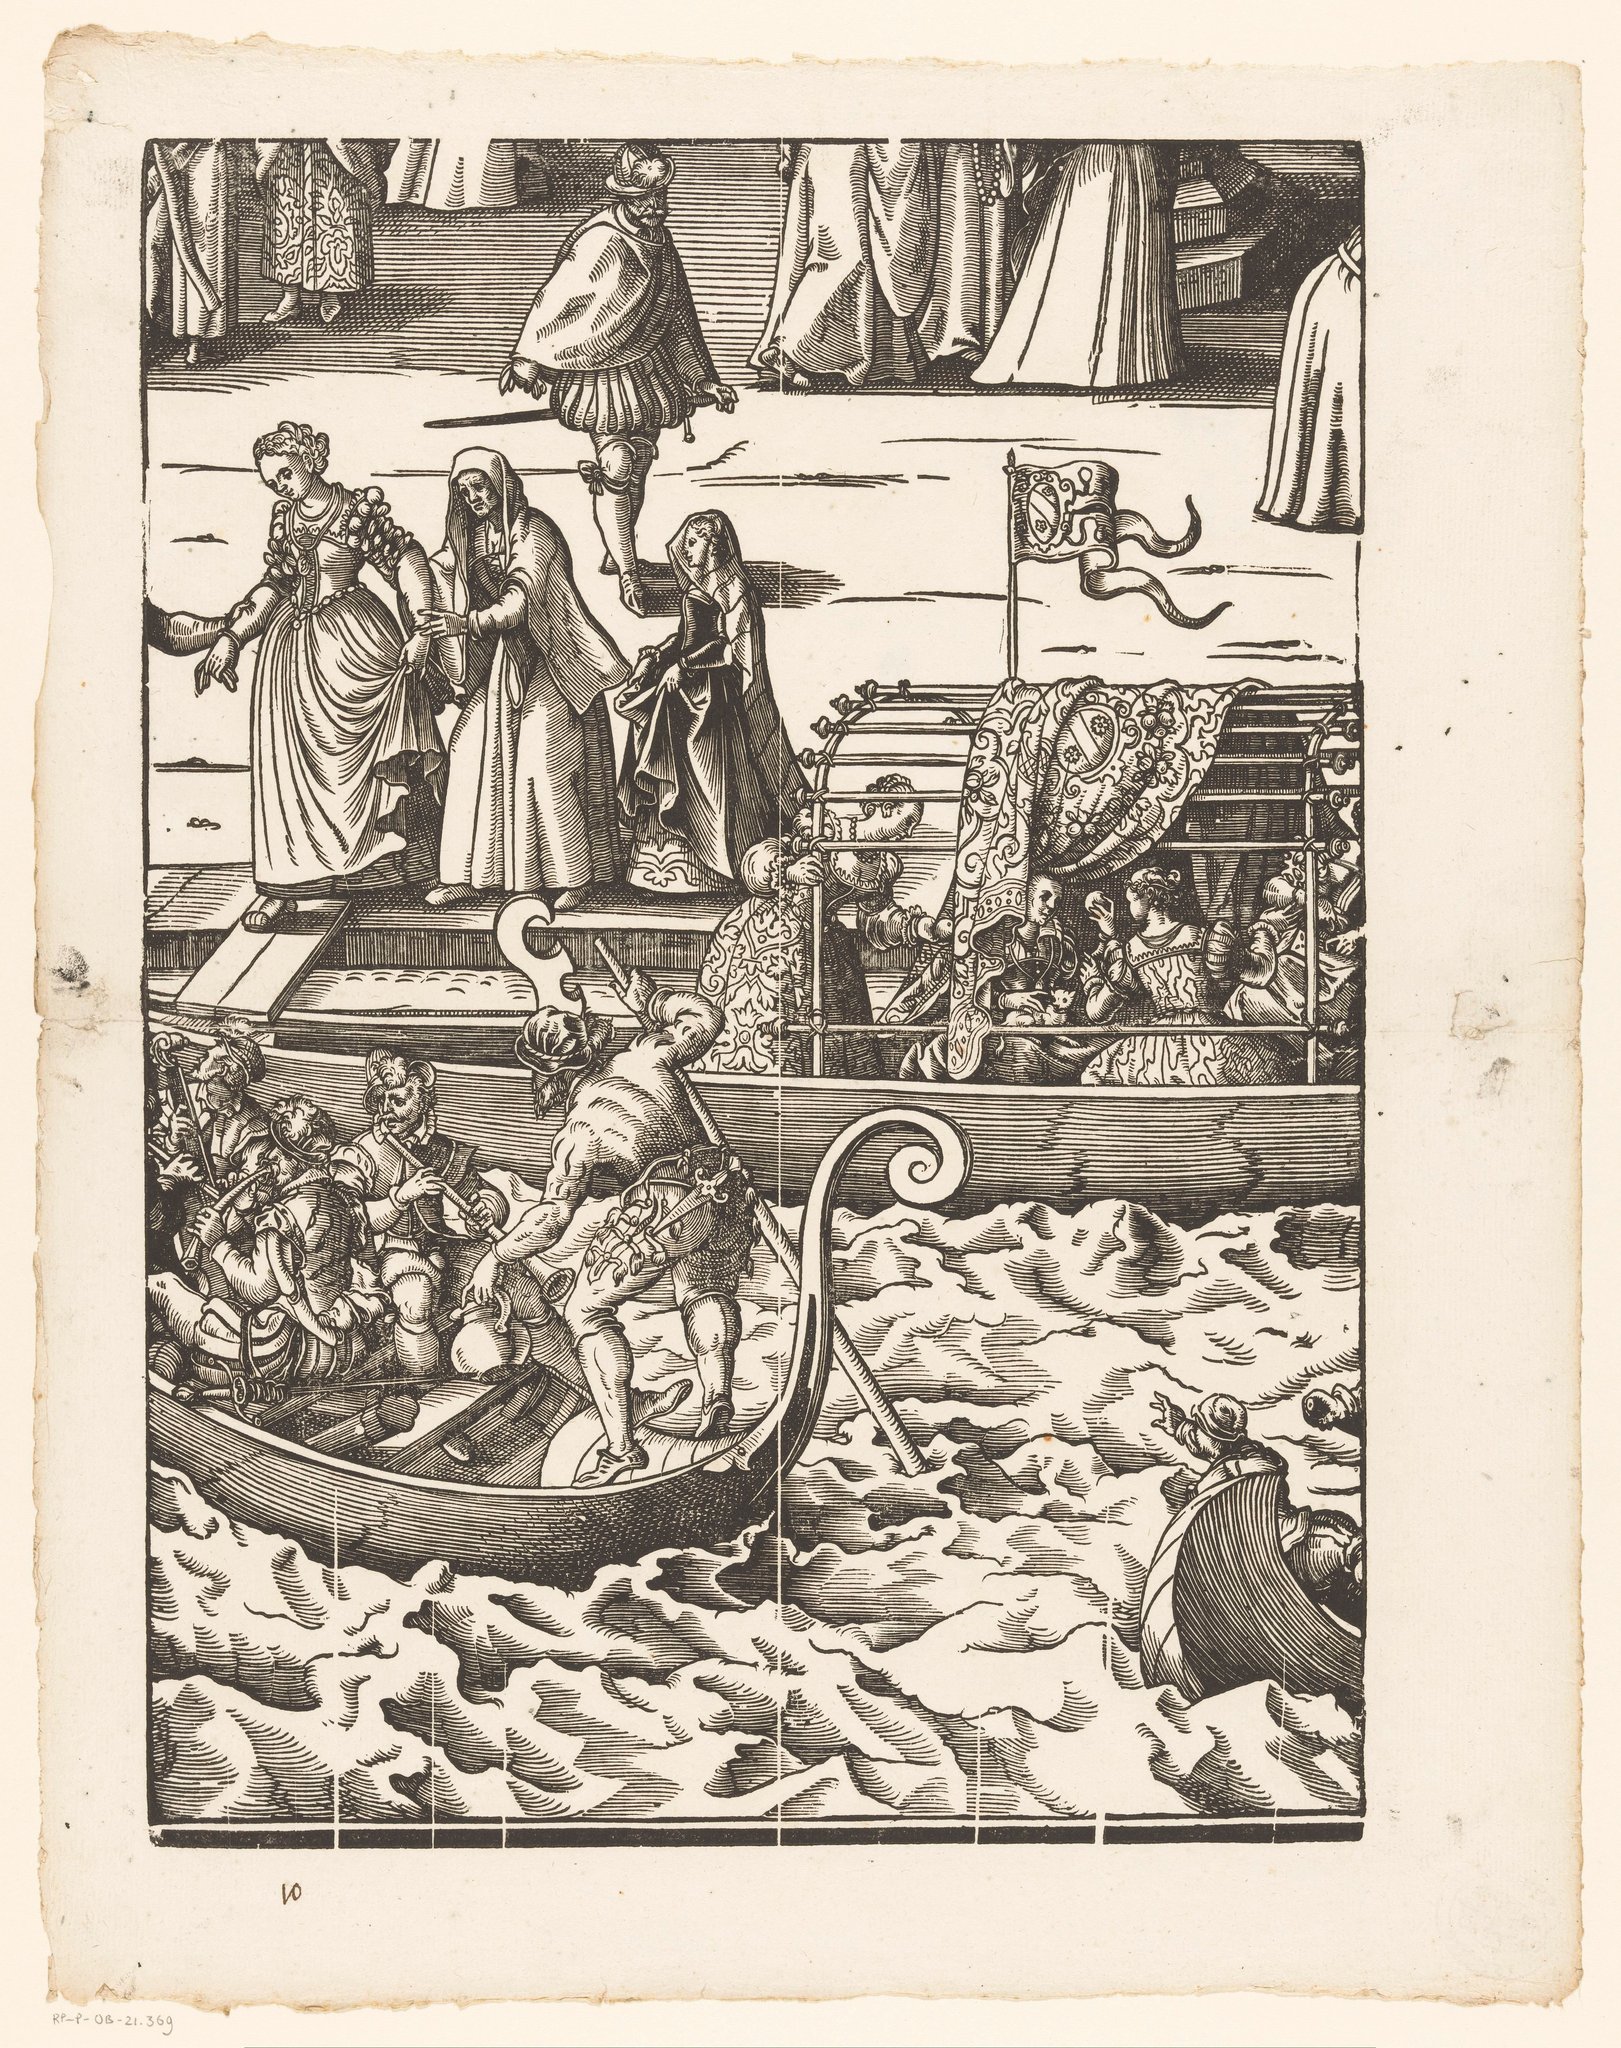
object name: print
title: Festa della Sensa (twaalfde gedeelte)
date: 1679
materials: paper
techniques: woodcut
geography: frankfurt am main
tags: fruits: apple, city-view in general; 'veduta', string instruments (bowed) - cc - out of doors, wind instruments - cc - out of doors, procession ~ christian religion, gondola, venice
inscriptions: collector's mark: Lugt 240, number: ‘10’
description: Twaalfde gedeelte van een grote voorstelling van de Festa della Sensa. De voorstelling is gedrukt van veertien blokken, de titel van vijf blokken en het onderschrift bestaat uit vijf delen van elk drie kolommen Duits tekst. In de collectie Rijksmuseum bevinden zich twee complete exemplaren inclusief titel en onderschrift. De veertien blokken die samen de voorstelling vormen zijn in de titels met de klok mee vanaf linksboven genummerd.